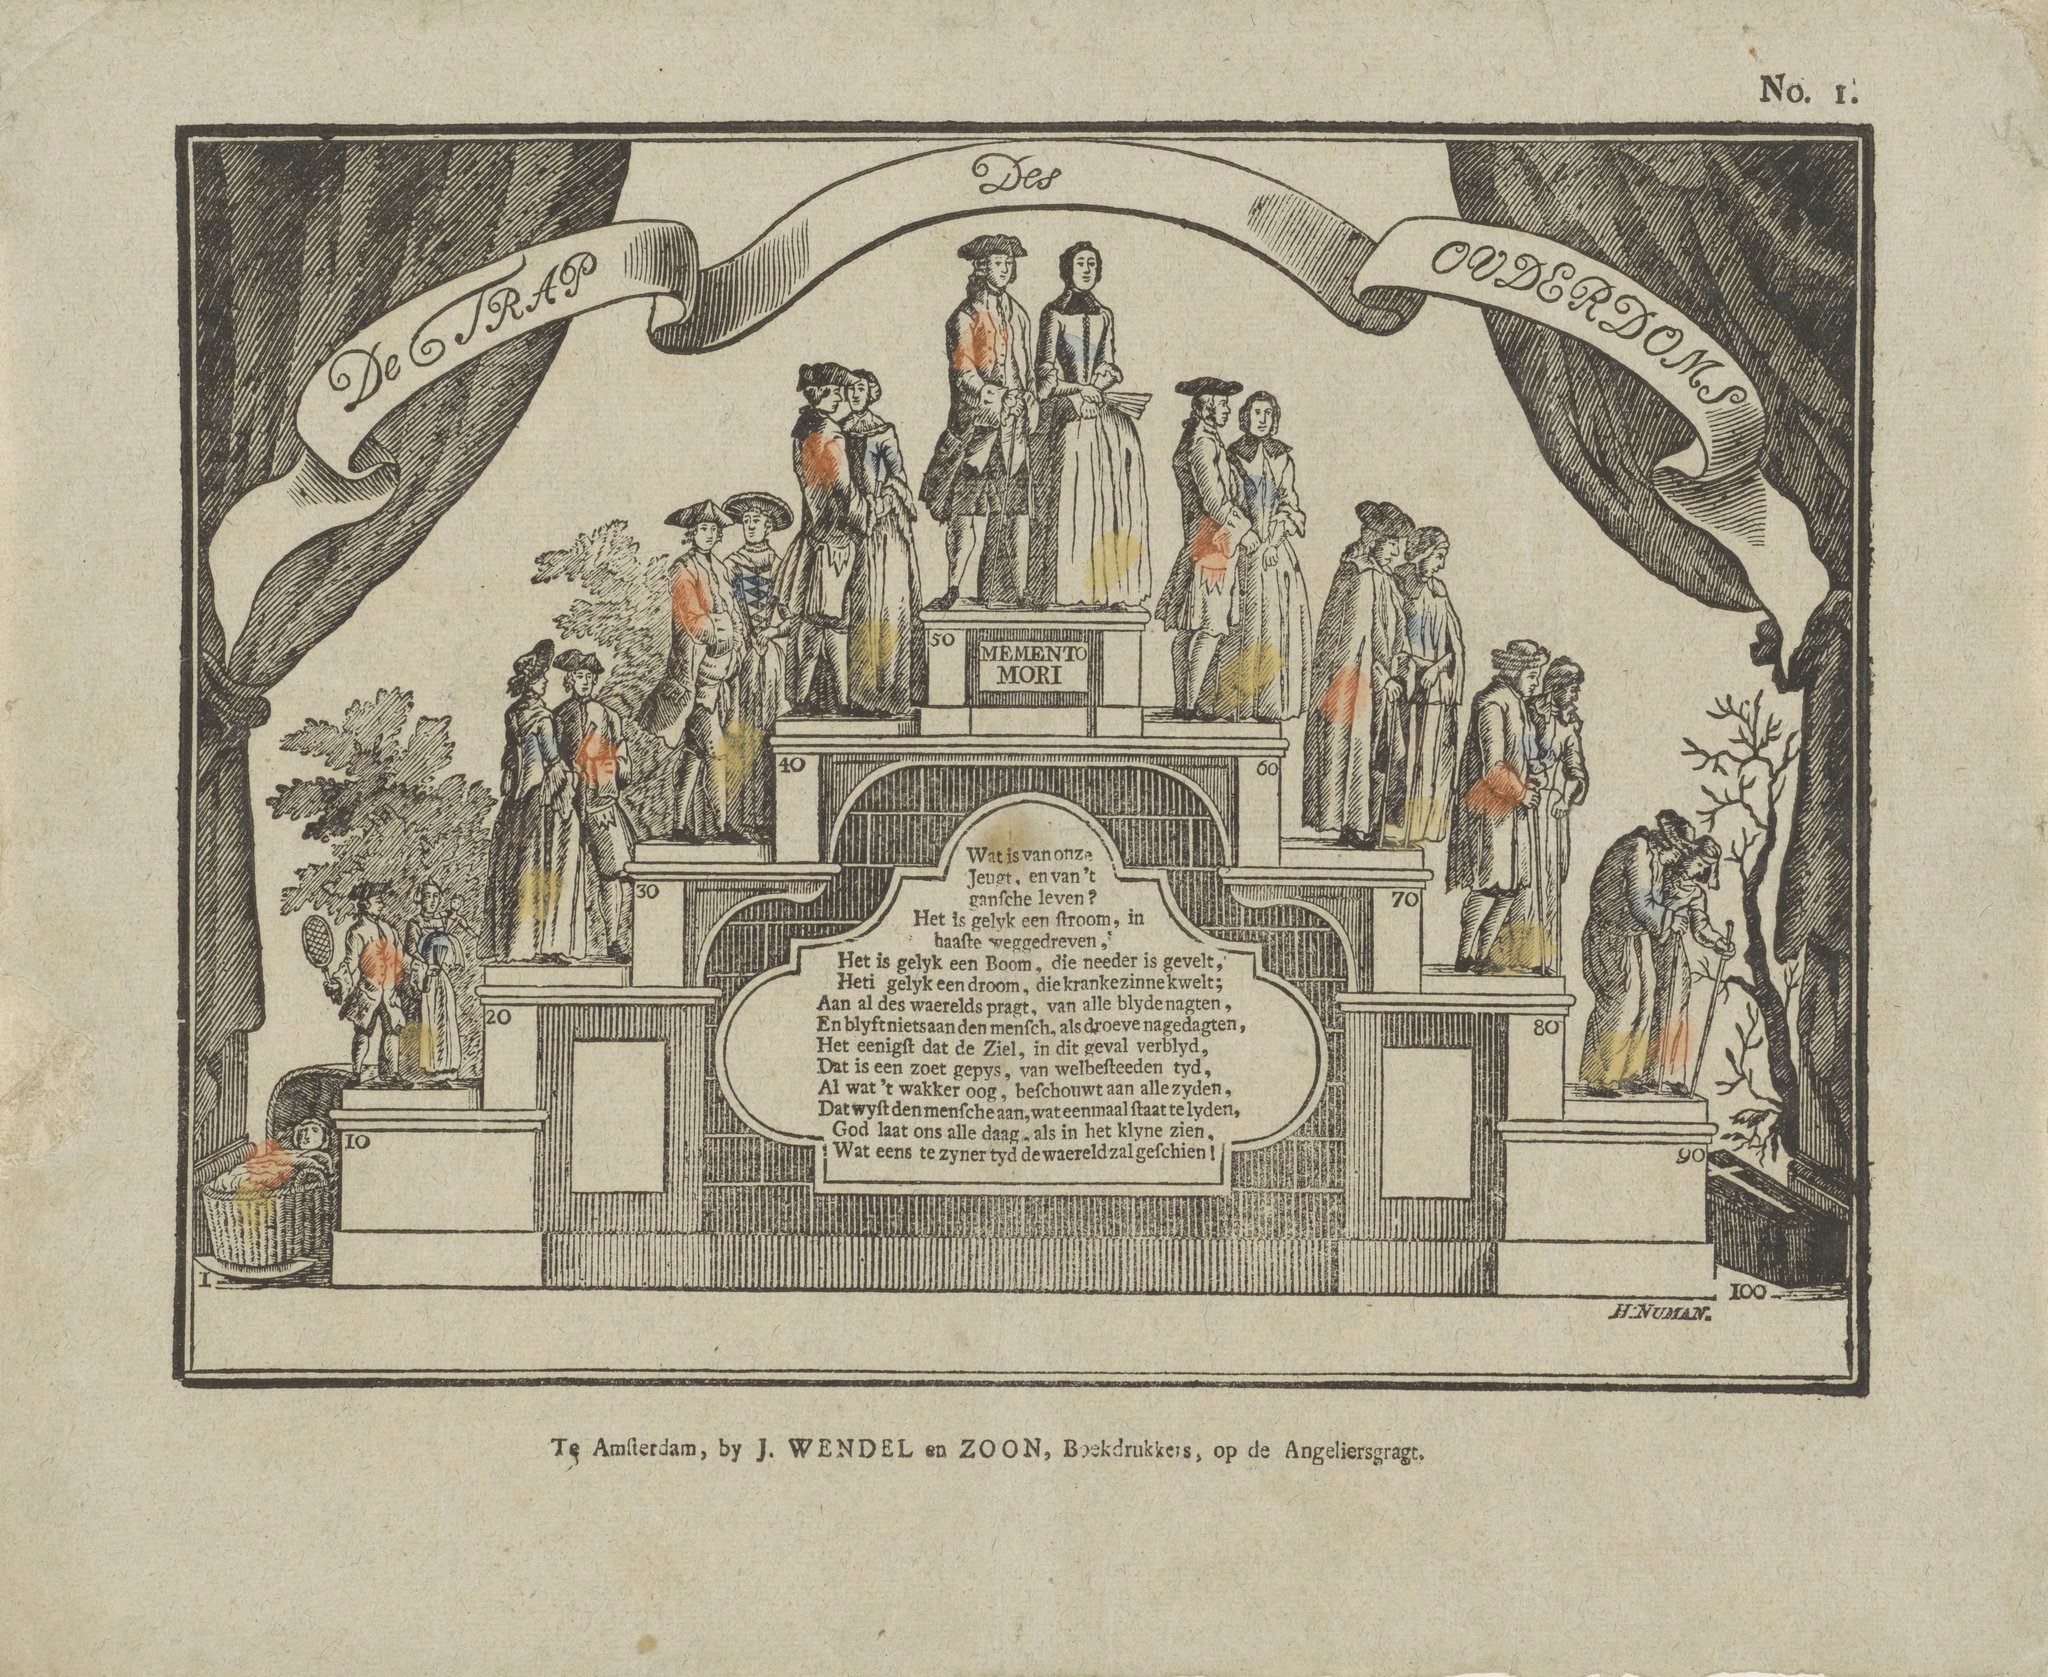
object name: popular print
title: De trap des ouderdoms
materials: paper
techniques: colour, letterpress printing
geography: amsterdam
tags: the ages of man represented by a staircase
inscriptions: collector's mark: Lugt 2760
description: Een trap des ouderdoms: een parentrap. Op de treden van de trap, in de vorm van een brug, staan mannen en vrouwen in de leeftijd van 0 tot 100 jaar. Onder de brug een cartouche met vers. Aan weerszijden van de voorstelling een gordijn. Genummerd rechtsboven: No. 1.